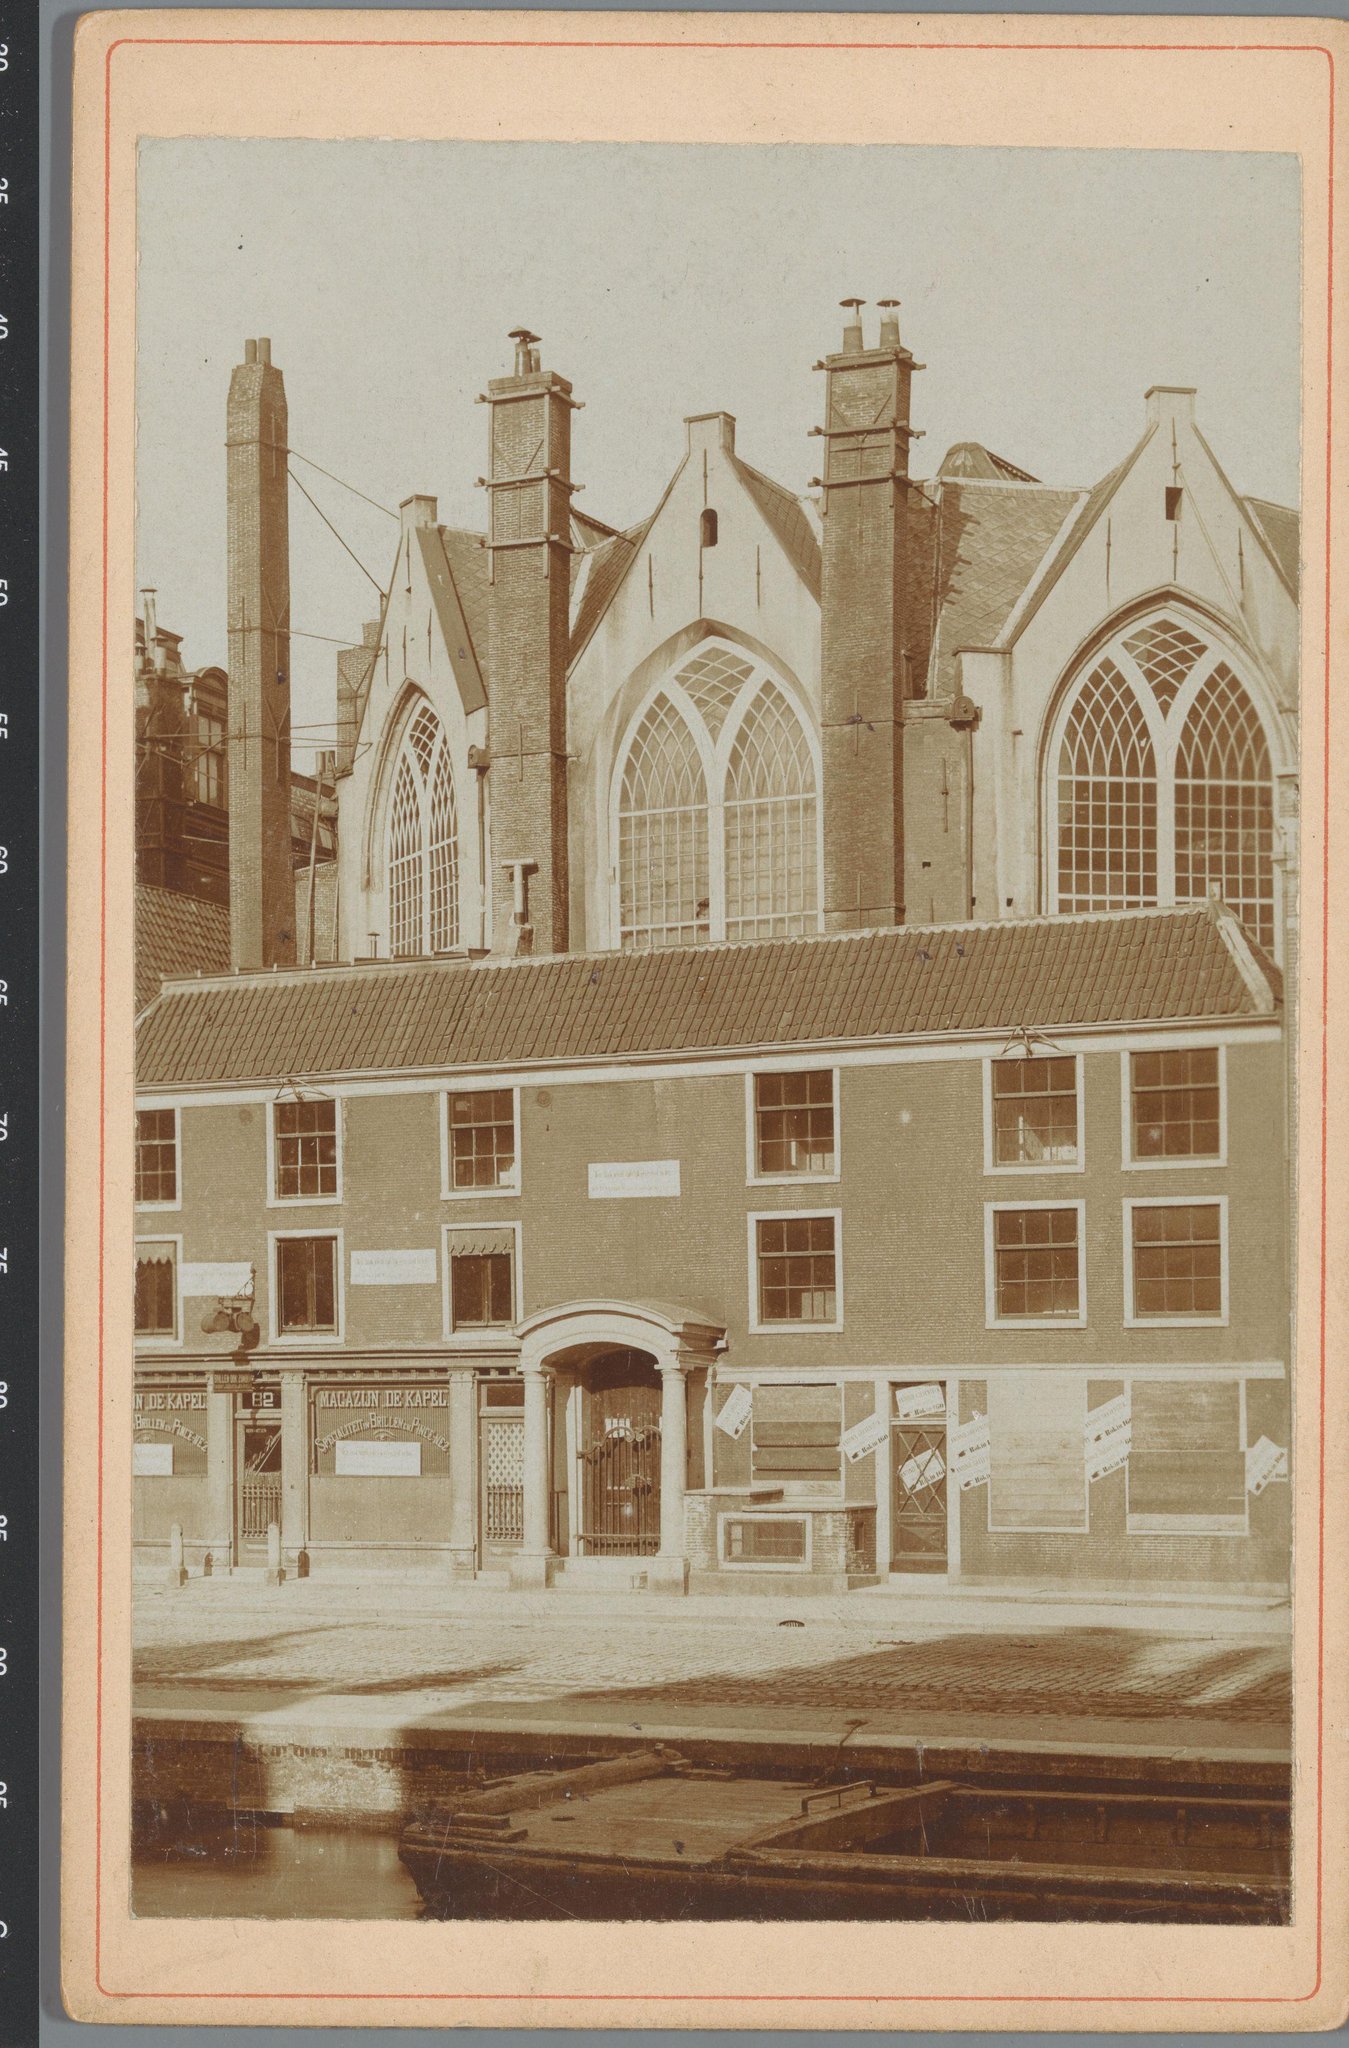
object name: cabinet photograph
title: Gezicht op de Nieuwezijds Kapel aan het Rokin in Amsterdam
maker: Anonymous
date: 1880-1900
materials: cardboard, photographic support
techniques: collodion silver print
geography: amsterdam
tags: shop, store, parts of church exterior and annexes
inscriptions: name: ‘Vosmaer’, inscription: ‘De voormalige Nieuwe Zijds Kapel aan het Rokin. Afgebroken en herbouwd.’, number: ‘410’